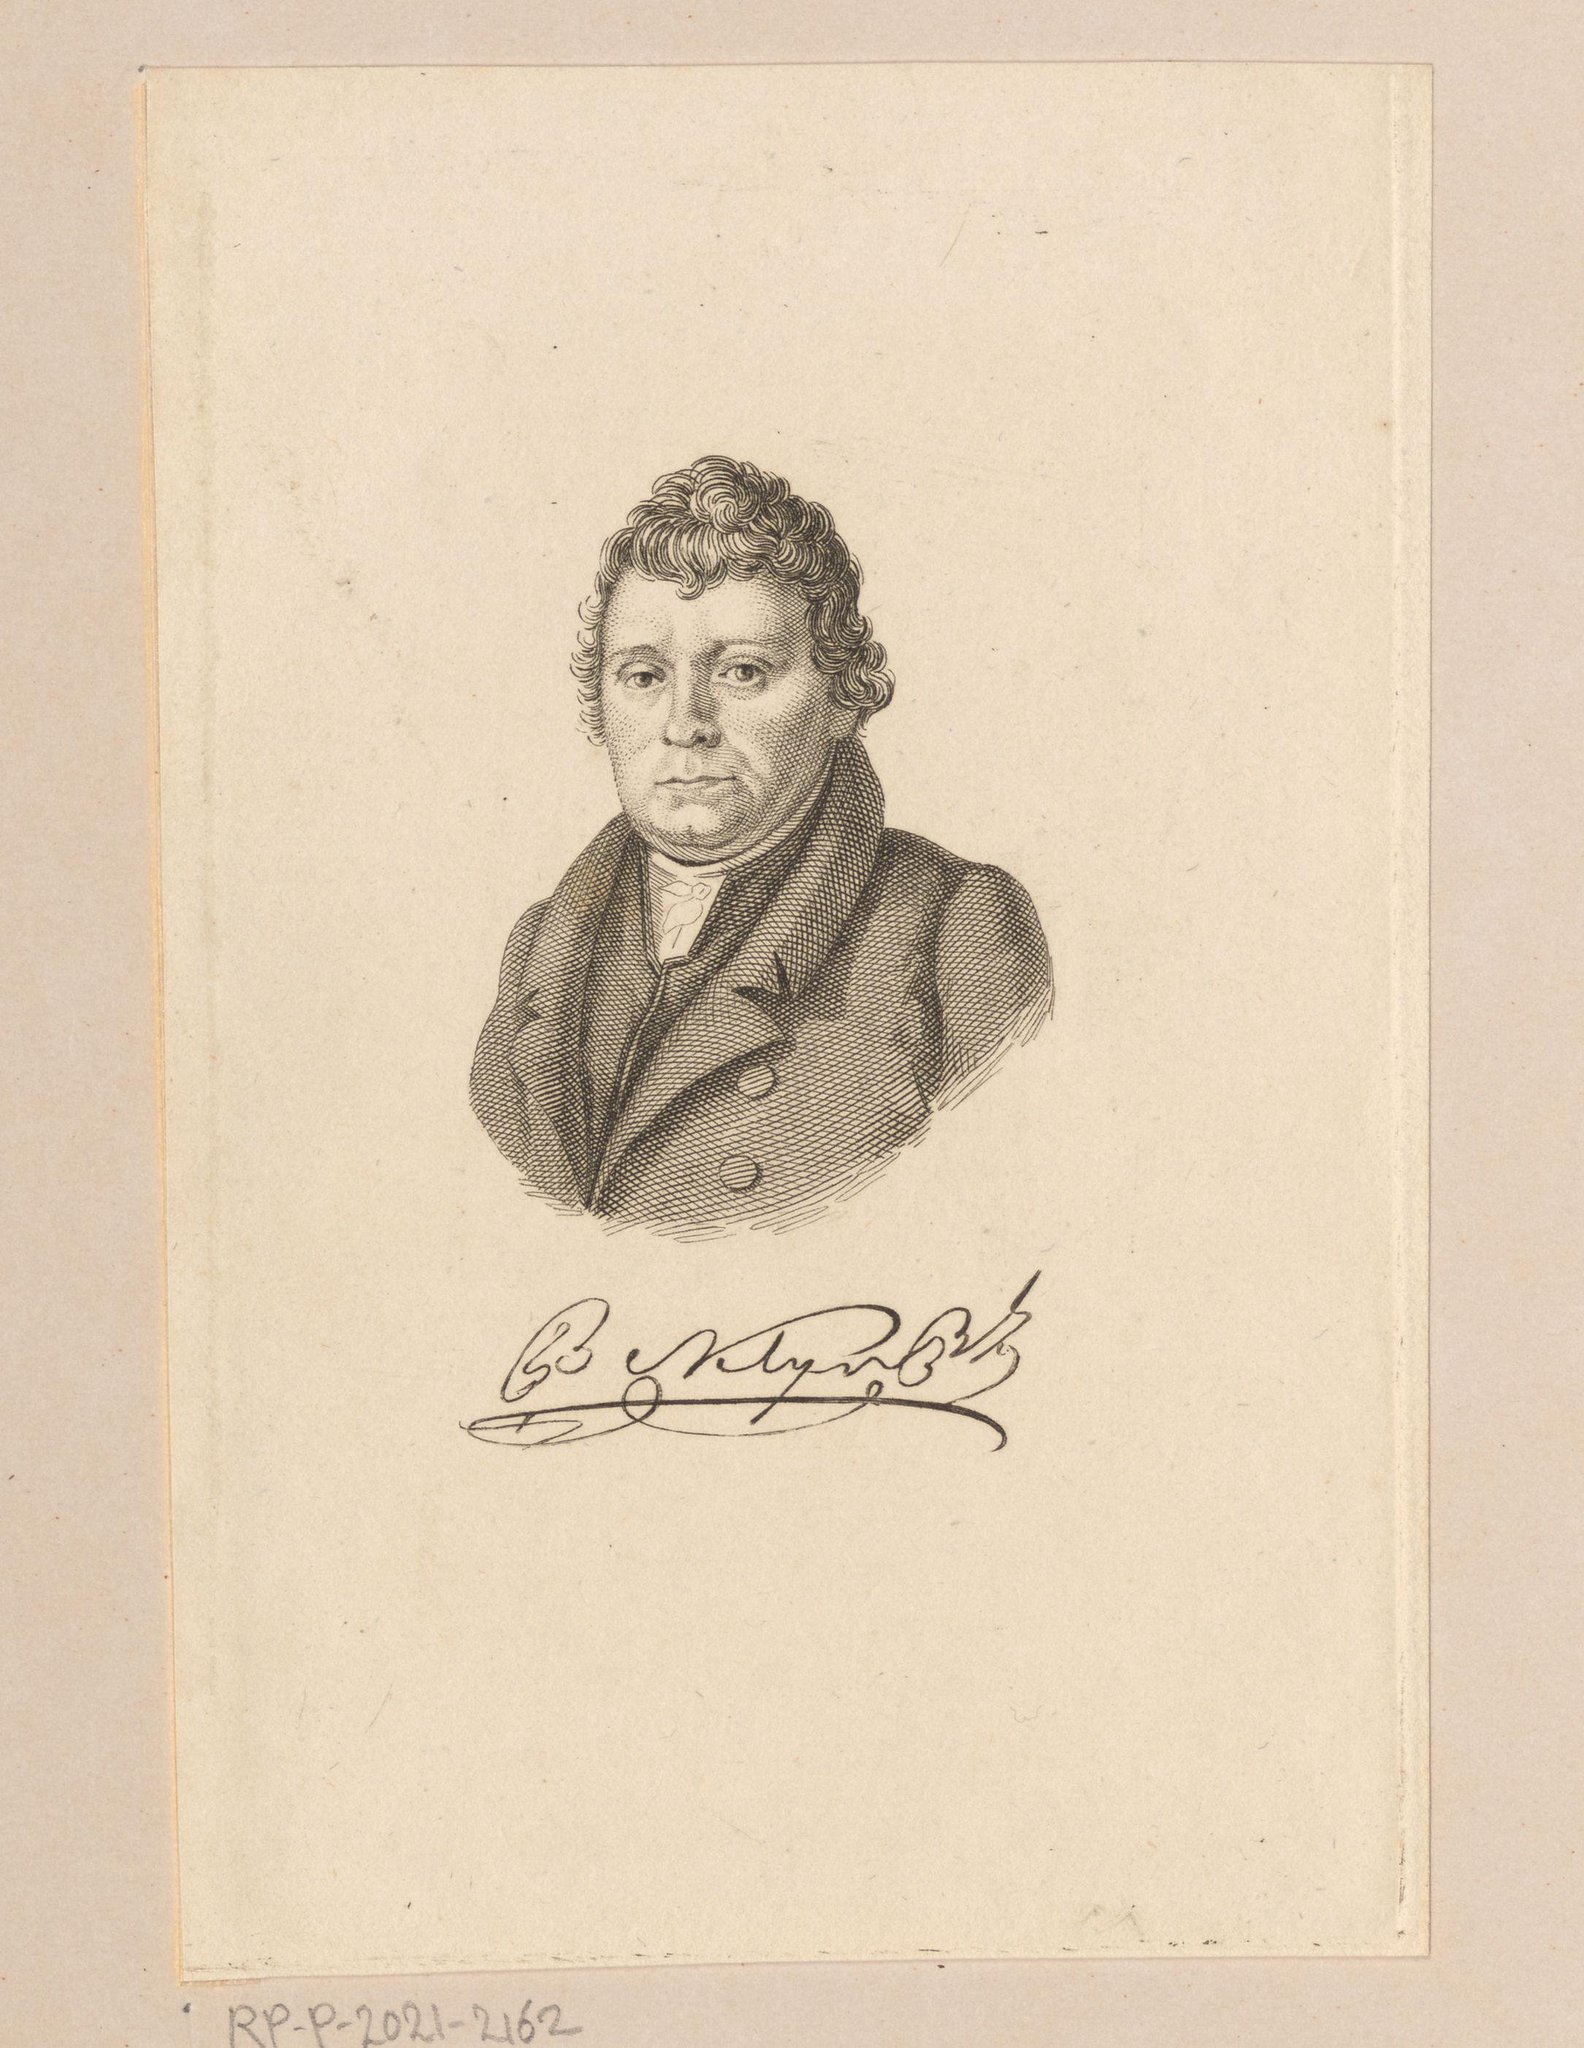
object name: print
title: Portret van Barend Klijn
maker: Anonymous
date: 1800-1849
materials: paper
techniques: engraving, etching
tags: amsterdam, manufacturer, barend klijn, historical persons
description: Onder het portret een facsimile van de handtekening van de geportretteerde.